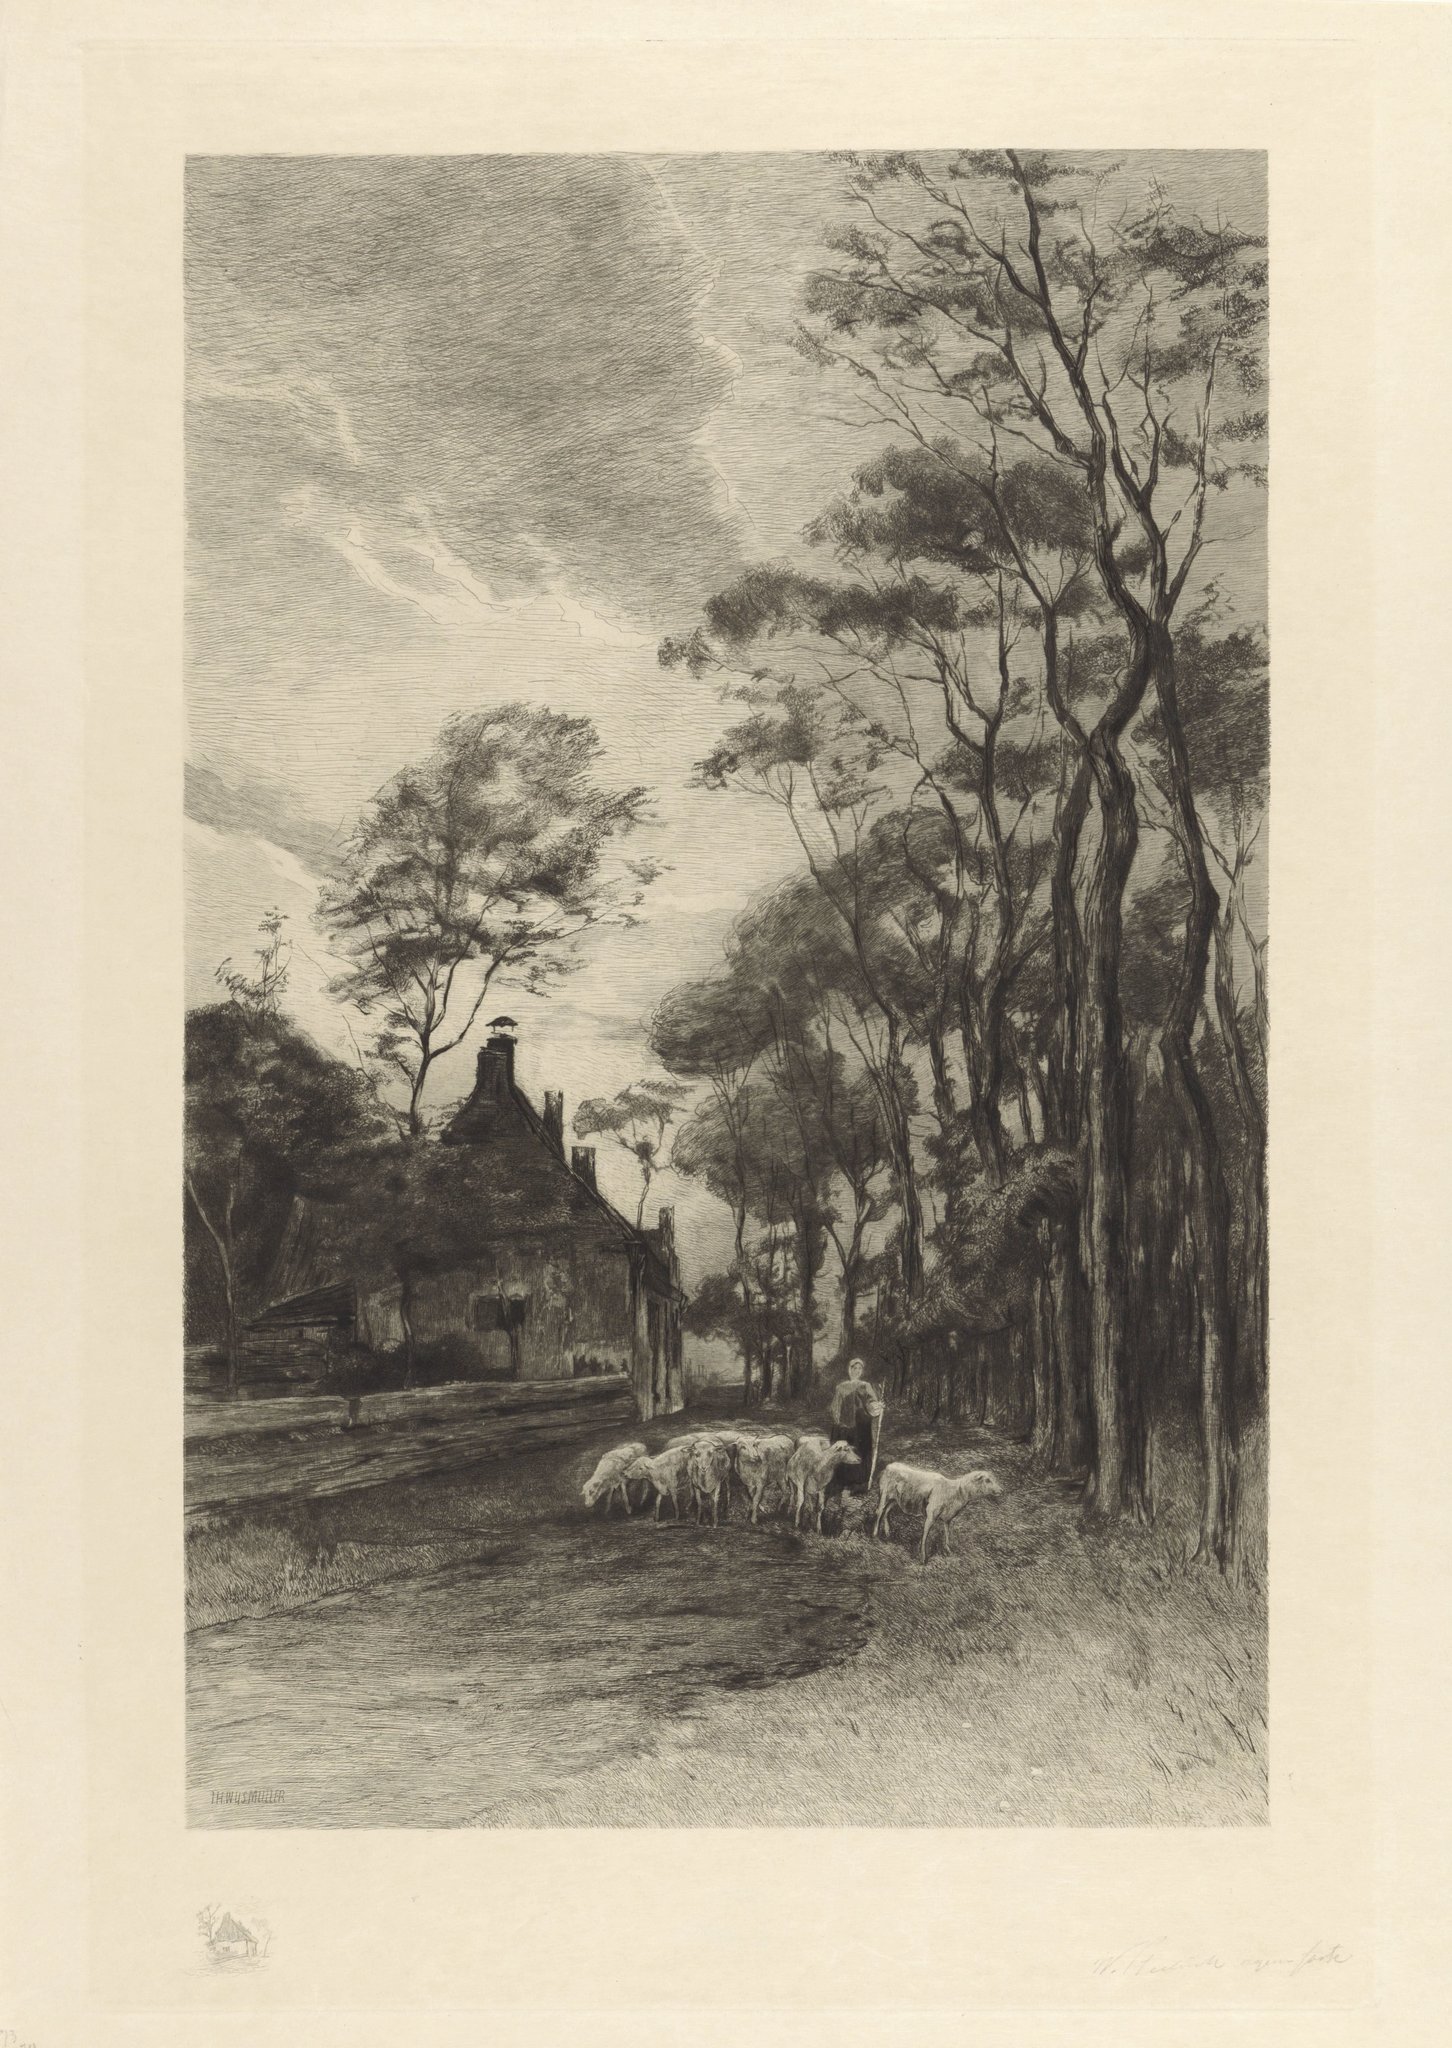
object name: print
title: Herderin met kudde schapen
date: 1866-1894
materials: paper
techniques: drypoint, etching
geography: netherlands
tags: herding, herdsman, herdswoman, shepherd, shepherdess, cowherd, etc.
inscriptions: collector's mark: Lugt 2228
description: Een herderin met een kudde schapen op een weg. Links een woning. Linksonder in de marge eveneens een woning.